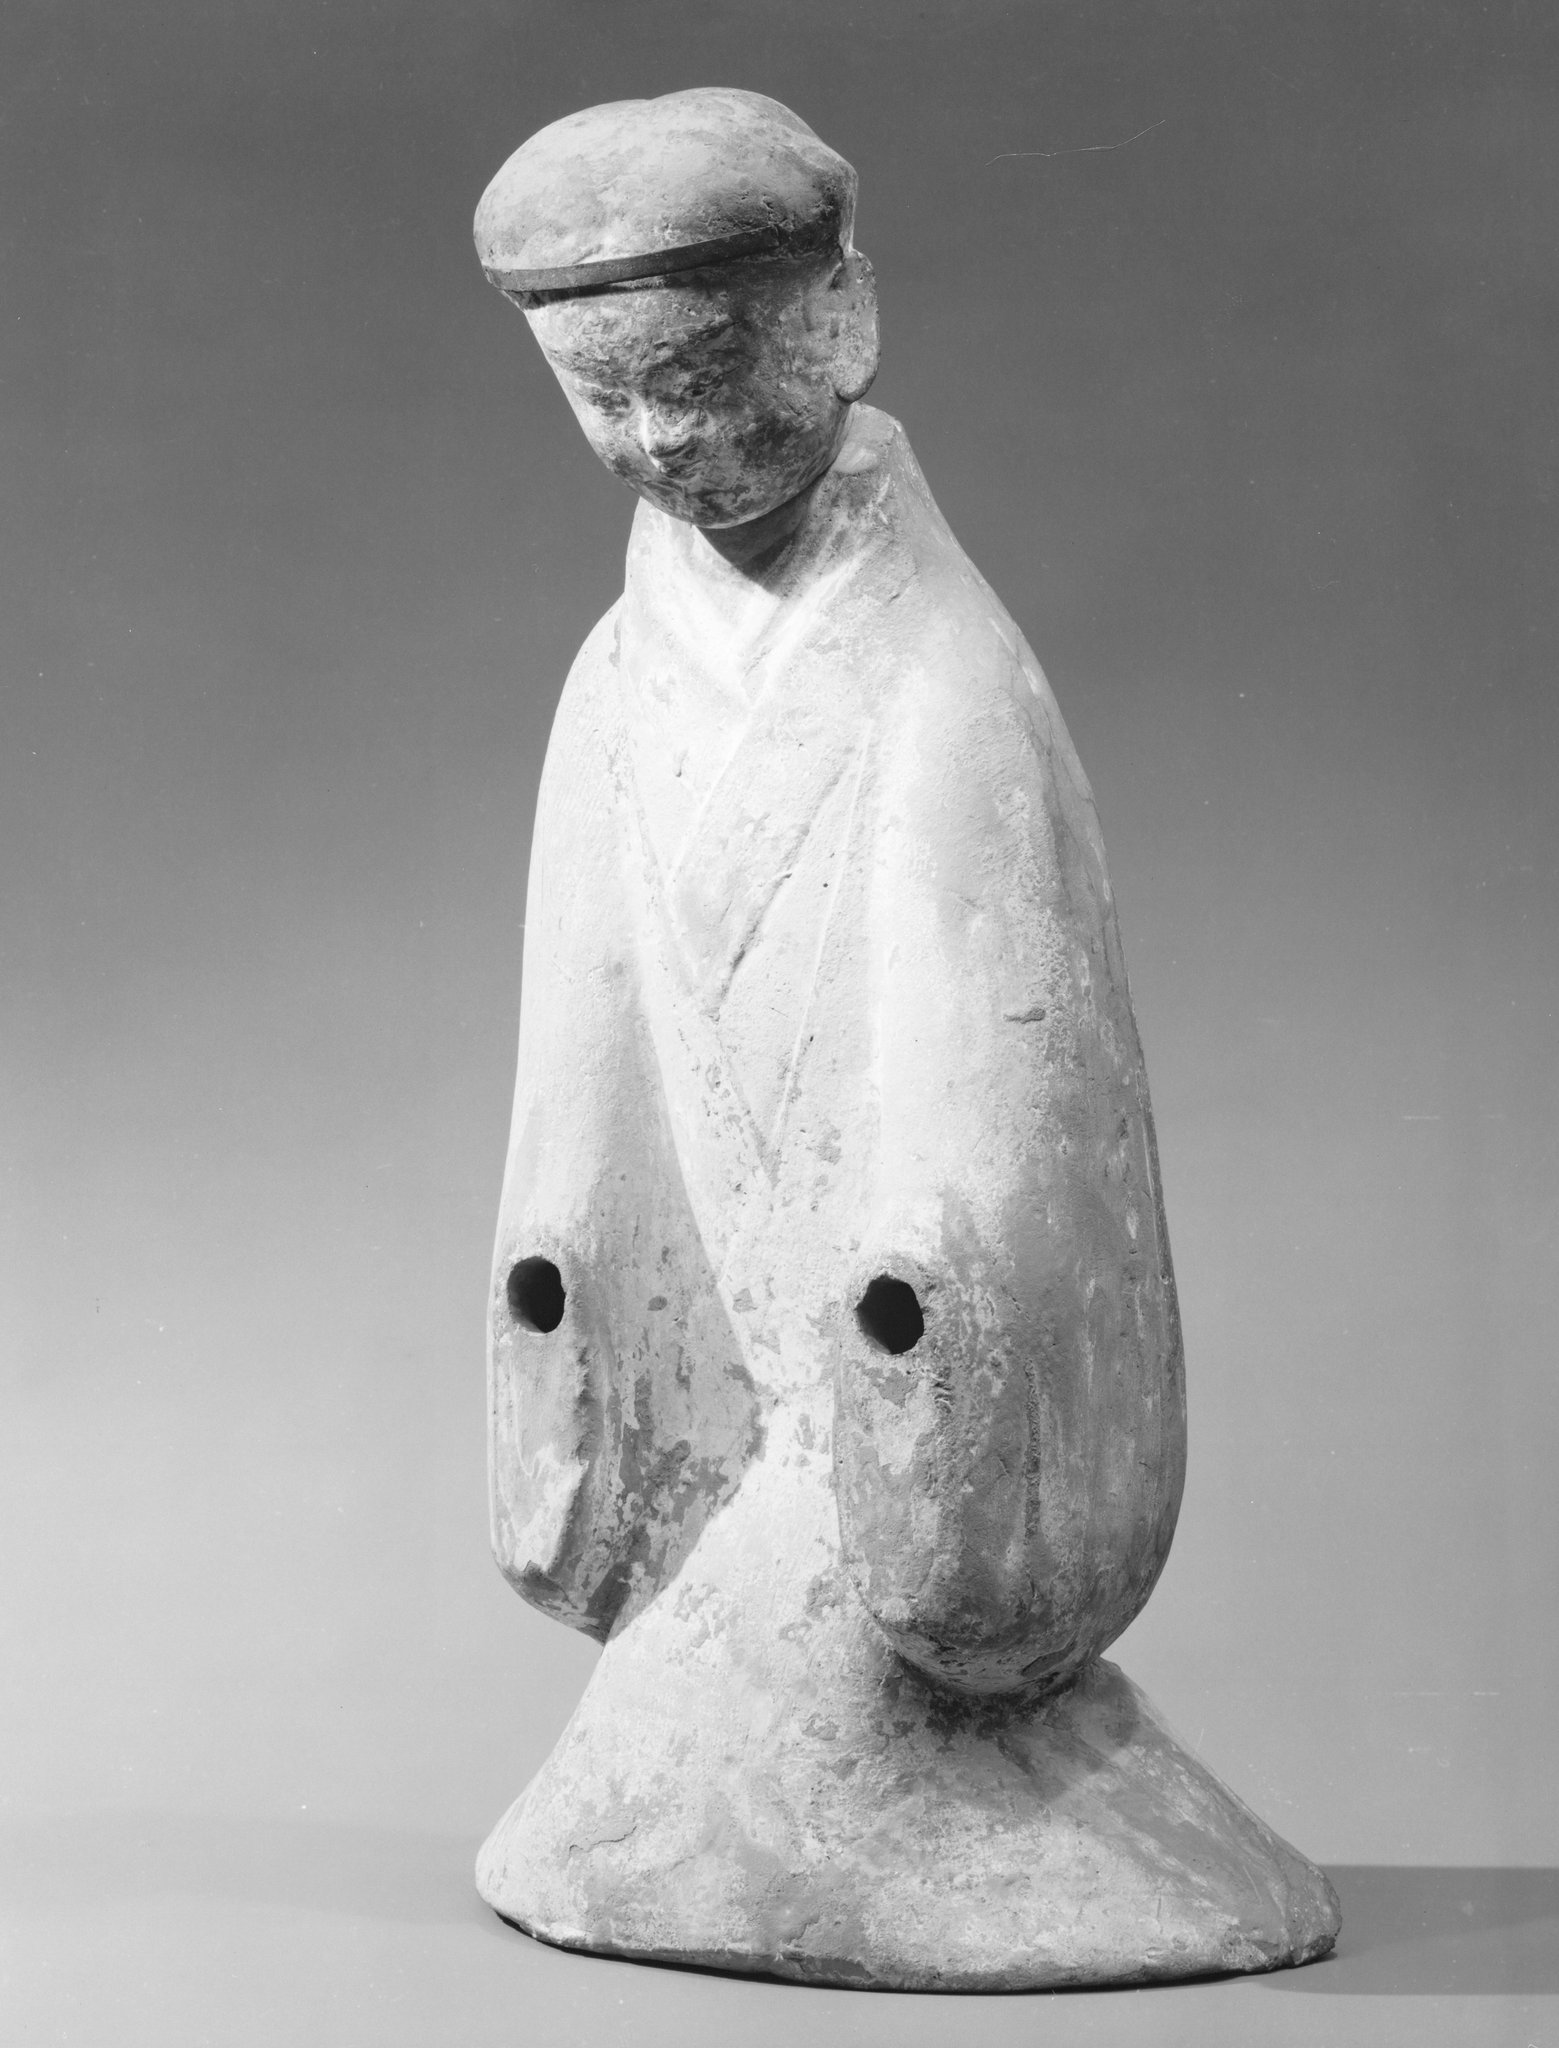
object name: figure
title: Figure with Removable Head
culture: chinese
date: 206 BCE-220 CE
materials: pottery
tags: human figures